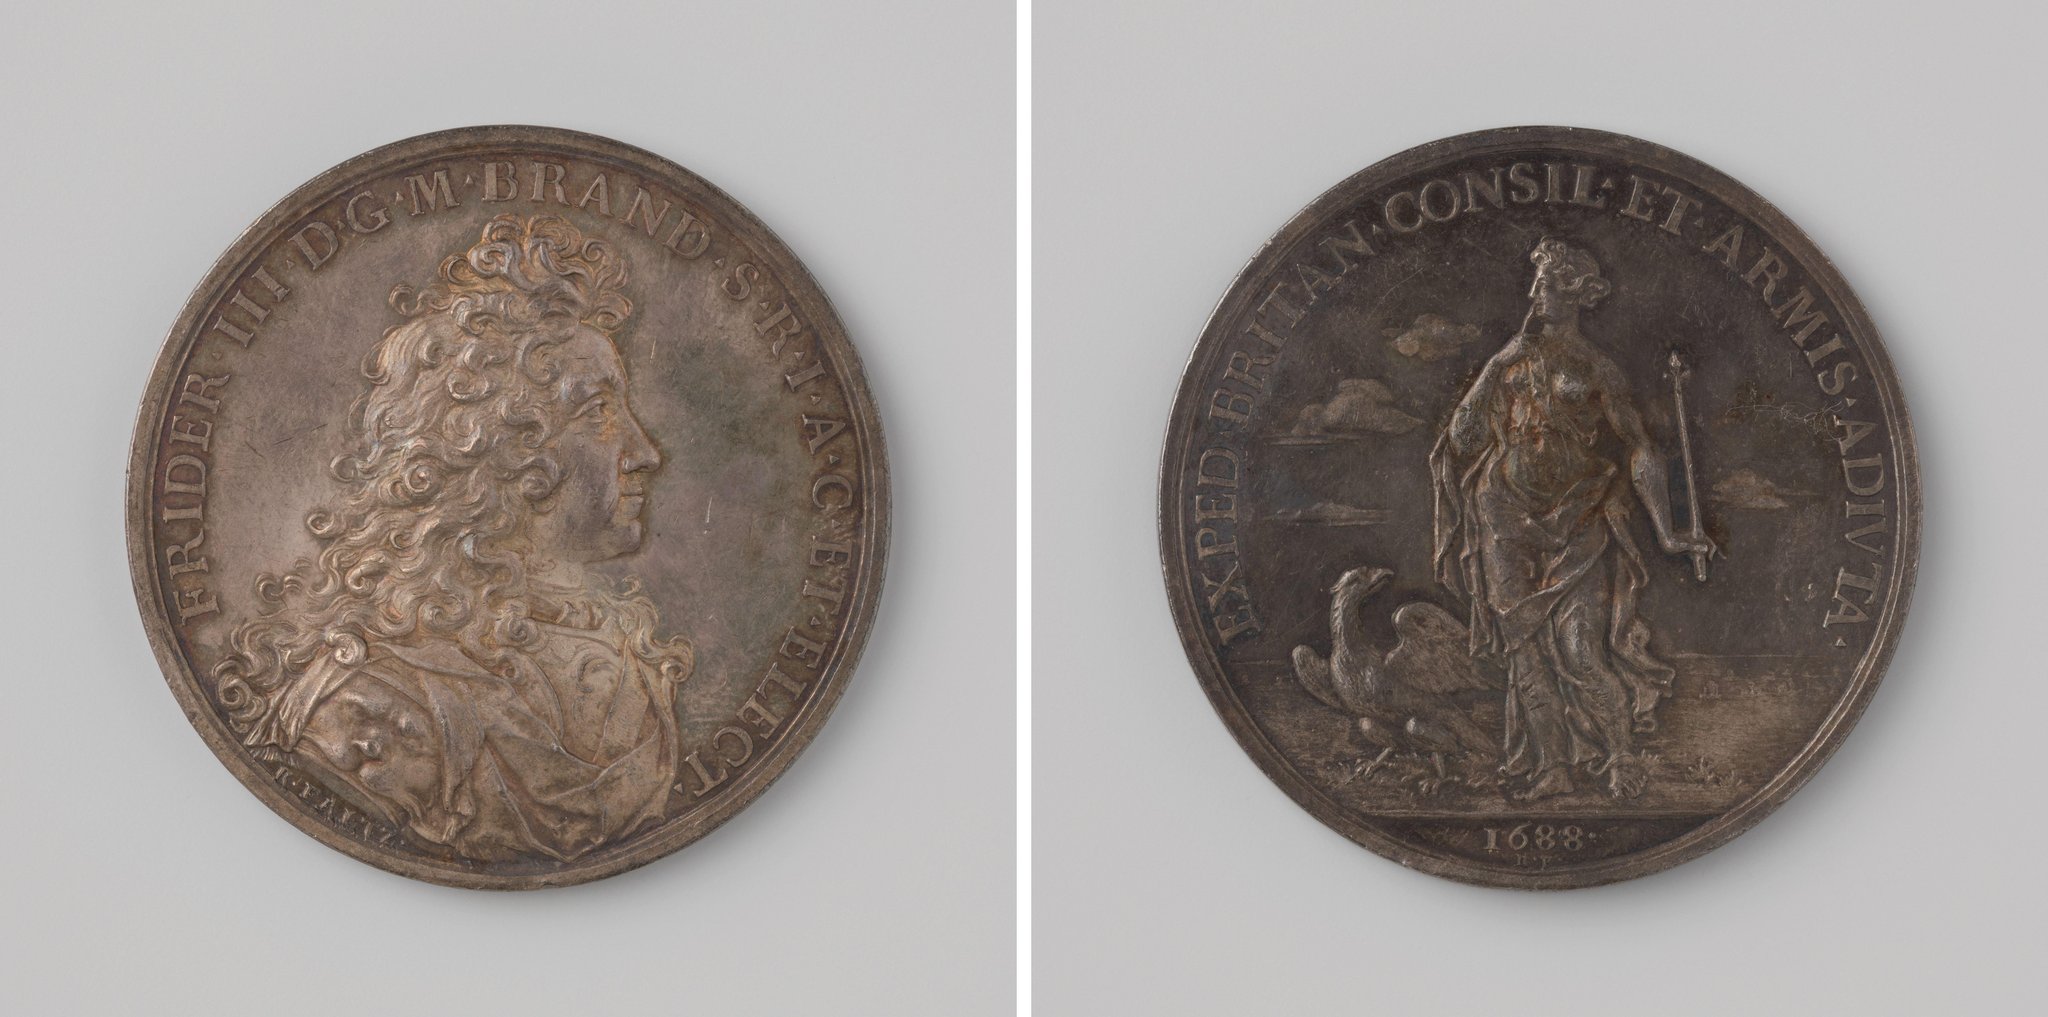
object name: history medal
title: Frederik III, keurvorst van Brandenburg verleent Willem III zijn bijstand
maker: raimund faltz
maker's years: 1658-1703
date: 1688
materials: silver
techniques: striking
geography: berlin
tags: william iii (prince of orange and king of england, scotland, and ireland), berlin, frederik i koning van pruisen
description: Zilveren penning. Voorzijde: borststuk man binnen omschrift. Keerzijde: Juno met scepter in hand legt vinger op haar mond ten teken van zwijgen binnen omschrift; afsnede: jaartal